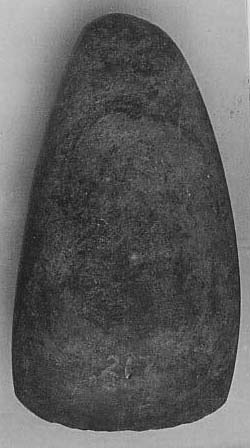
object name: hatchet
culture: french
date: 1902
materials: jade